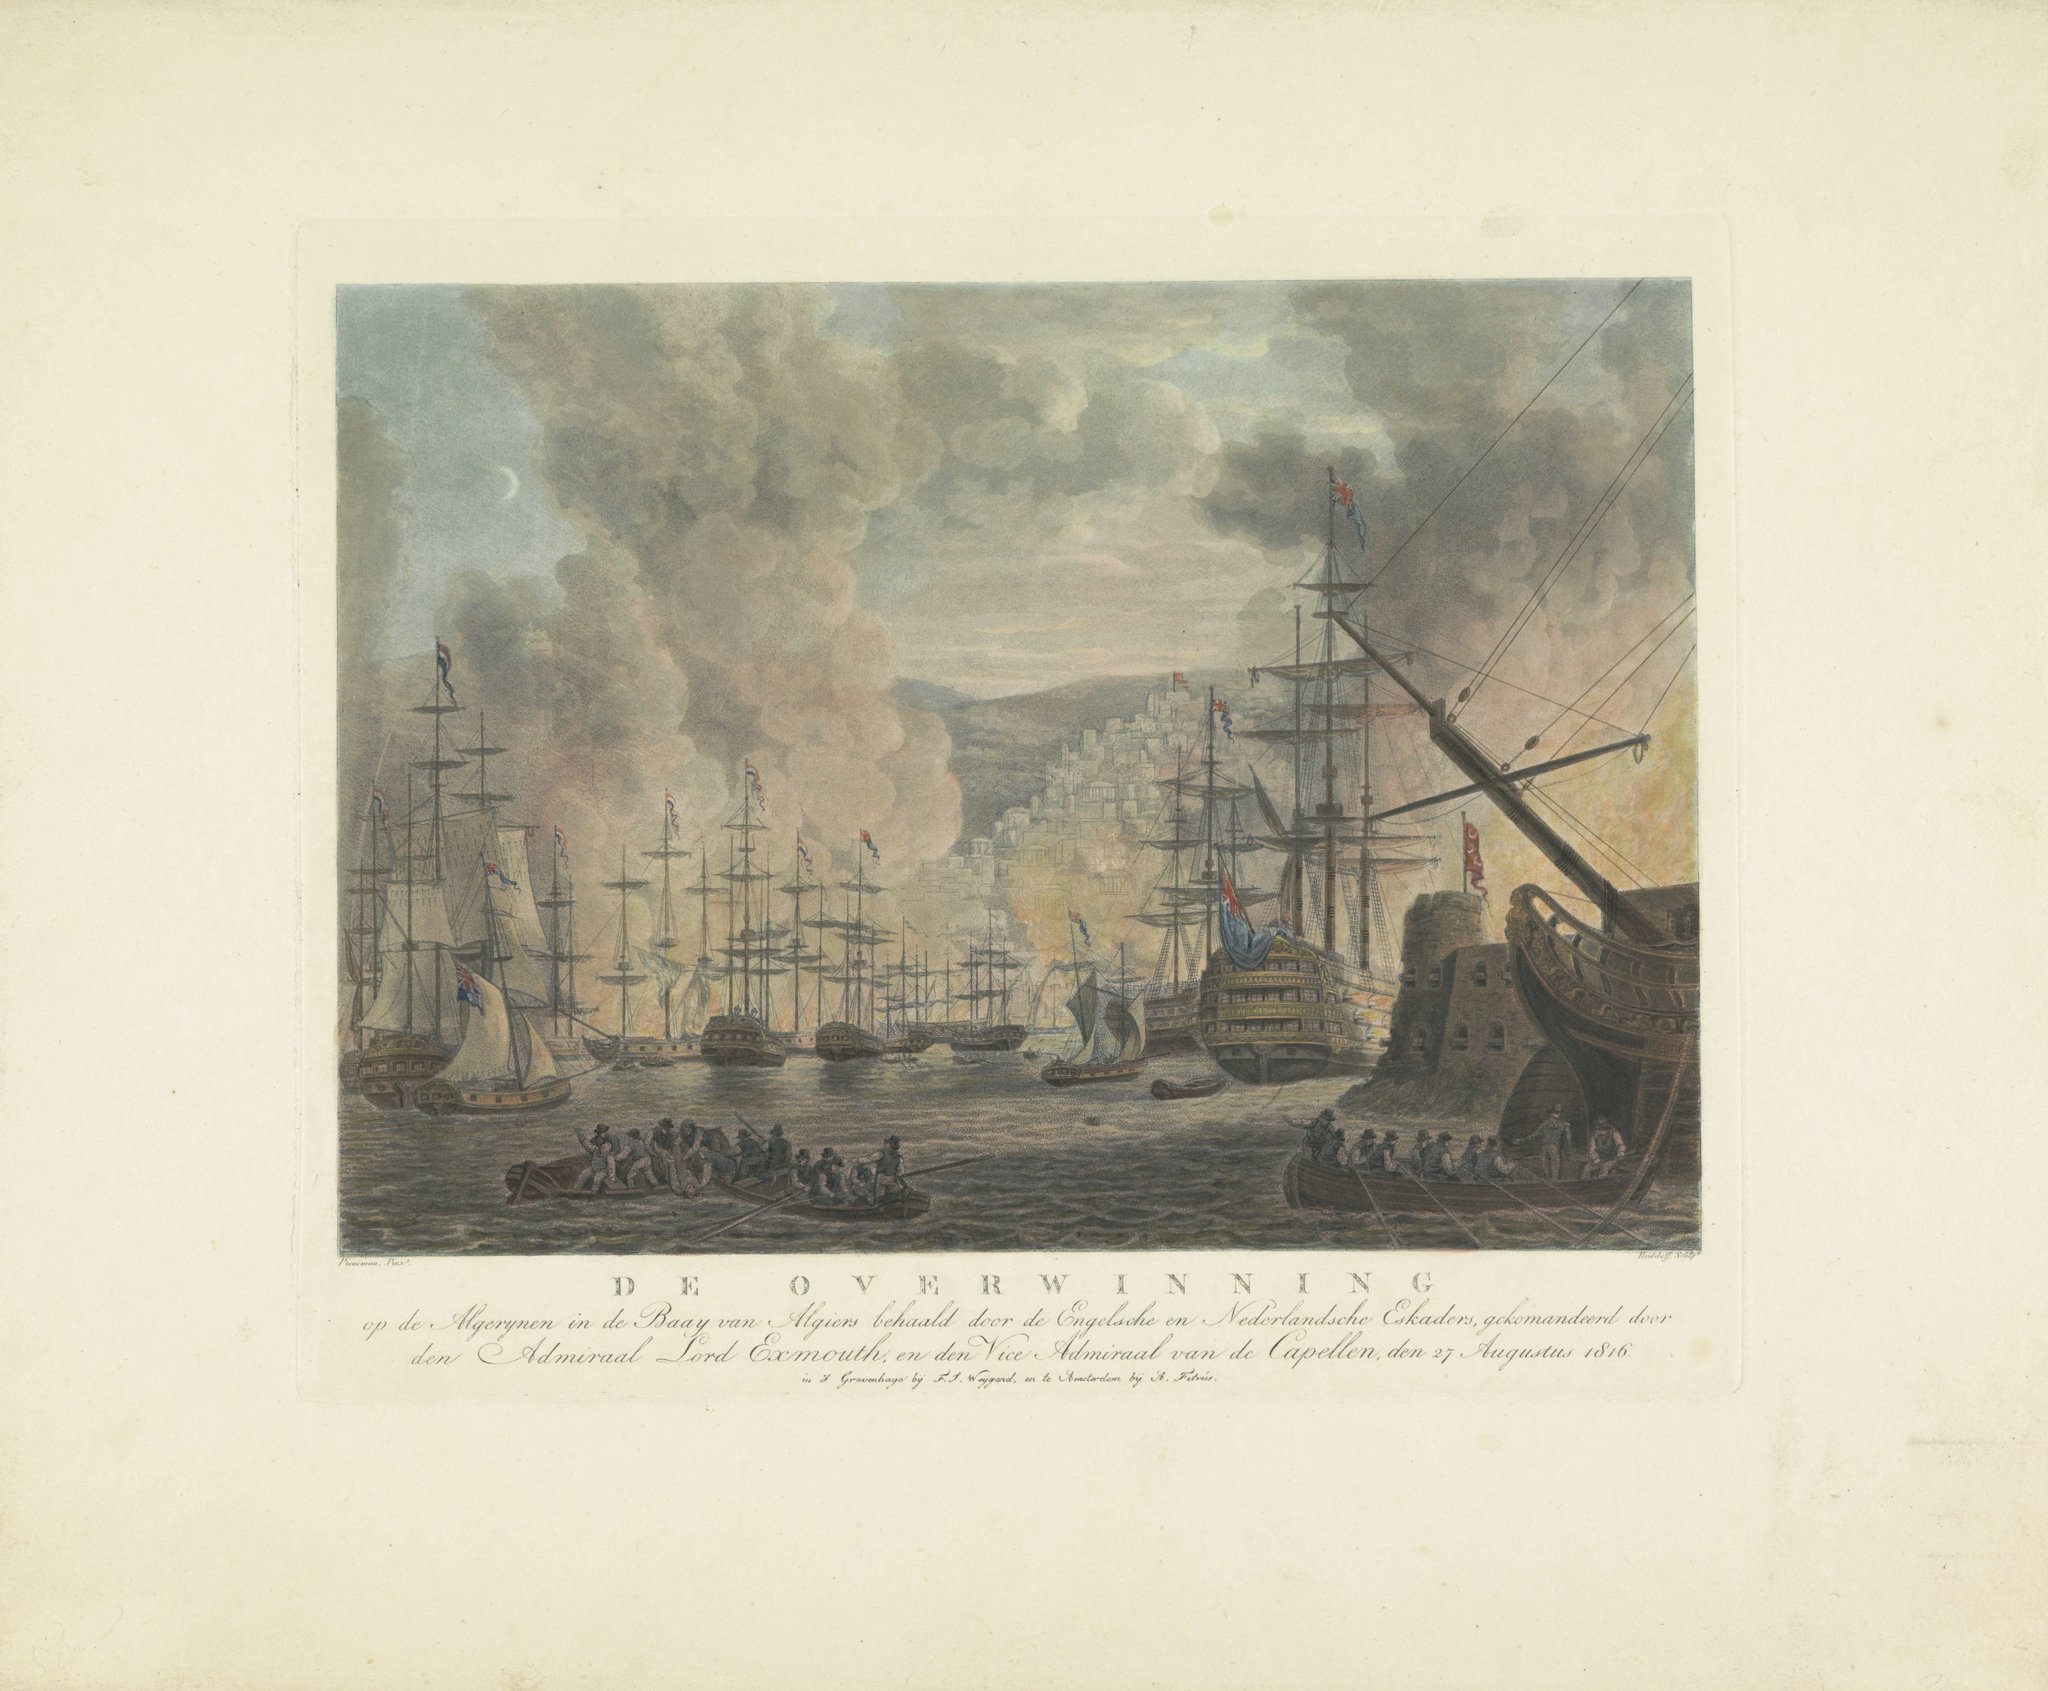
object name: print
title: Bombardement van Algiers, 1816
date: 1816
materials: paper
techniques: aquatint, etching, hand coloring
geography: amsterdam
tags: nijmegen, brussels, bombardment (+ sailing-ships), bombardment ~ siege (+ sailing-ships)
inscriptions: collector's mark: Lugt 2228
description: Het bombardement van Algiers in de nacht van 26-27 augustus 1816 door de gecombineerde Engels-Nederlandse vloot, onder commando van Lord Exmouth en jonkheer van Capellen. Links en rechts de brandende schepen van de zeerovers, in het midden de stad gelegen op een heuvel. Op de voorgrond enkele sloepen. Rechts een kustbatterij waarop een vlag met drie maansikkels.